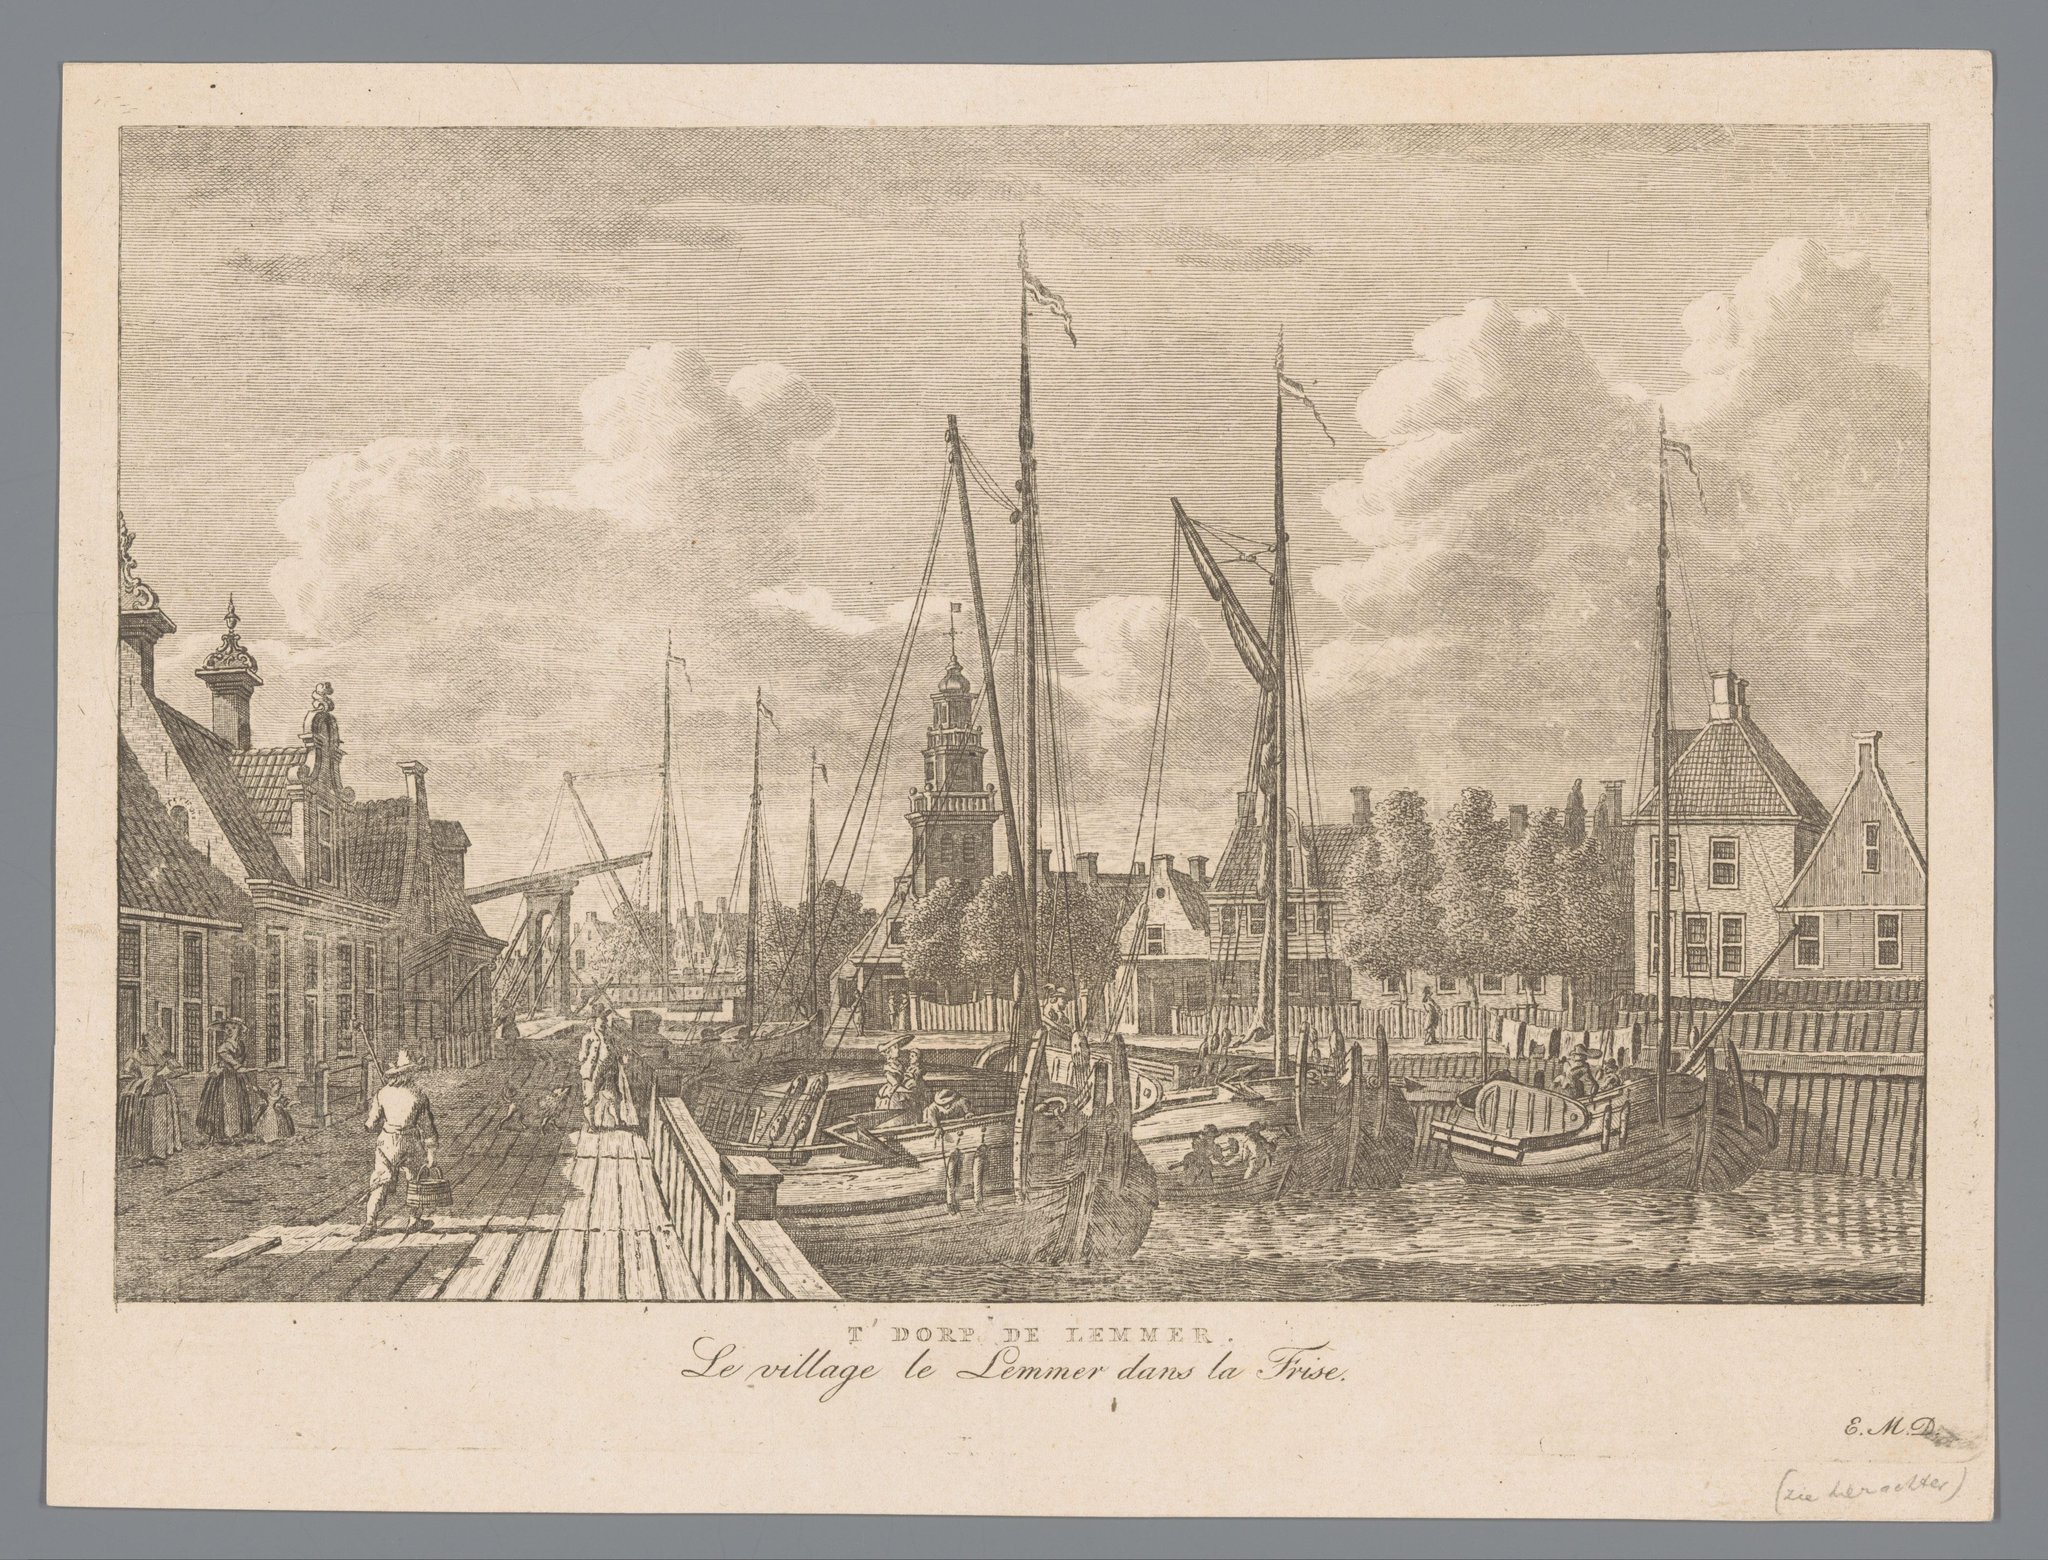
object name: print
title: T' Dorp De Lemmer / Le village le Lemmer dans la Frise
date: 1786-1792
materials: paper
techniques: etching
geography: amsterdam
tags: harbour, village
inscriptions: collector's mark: Lugt 2227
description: Huidige staat van prent uitgegeven als onderdeel van een plaatwerk uit ca. 1824-1825 met 74 (ongenummerde) platen van de belangrijkste topografische gezichten en verschillende zeden en gewoonten in het Verenigd Koninkrijk der Nederlanden, getiteld 'Tableau des principales vues des palais et édifices : représentations et des coutumes et usages, dans les provinces septentrionales du Royaume des Pays-Bas'. Eerdere staat gebruikt in: Vaderlandsche gezichten, of afbeeldingen van den tegenwoordigen staat der Vereenigde Nederlanden (…). Amsterdam: Hendrik Gartman, Willem Vermandel en Jan Willem Smit, 1786-1792. Uitgegeven in afleveringen met ieder een eigen bifolium en inhoudsopgave. Alle prenten in deze publicatie zijn gegraveerd door Carel Frederik Bendorp (I) en, in de meeste gevallen, gebaseerd op tekeningen van Jan Bulthuis.